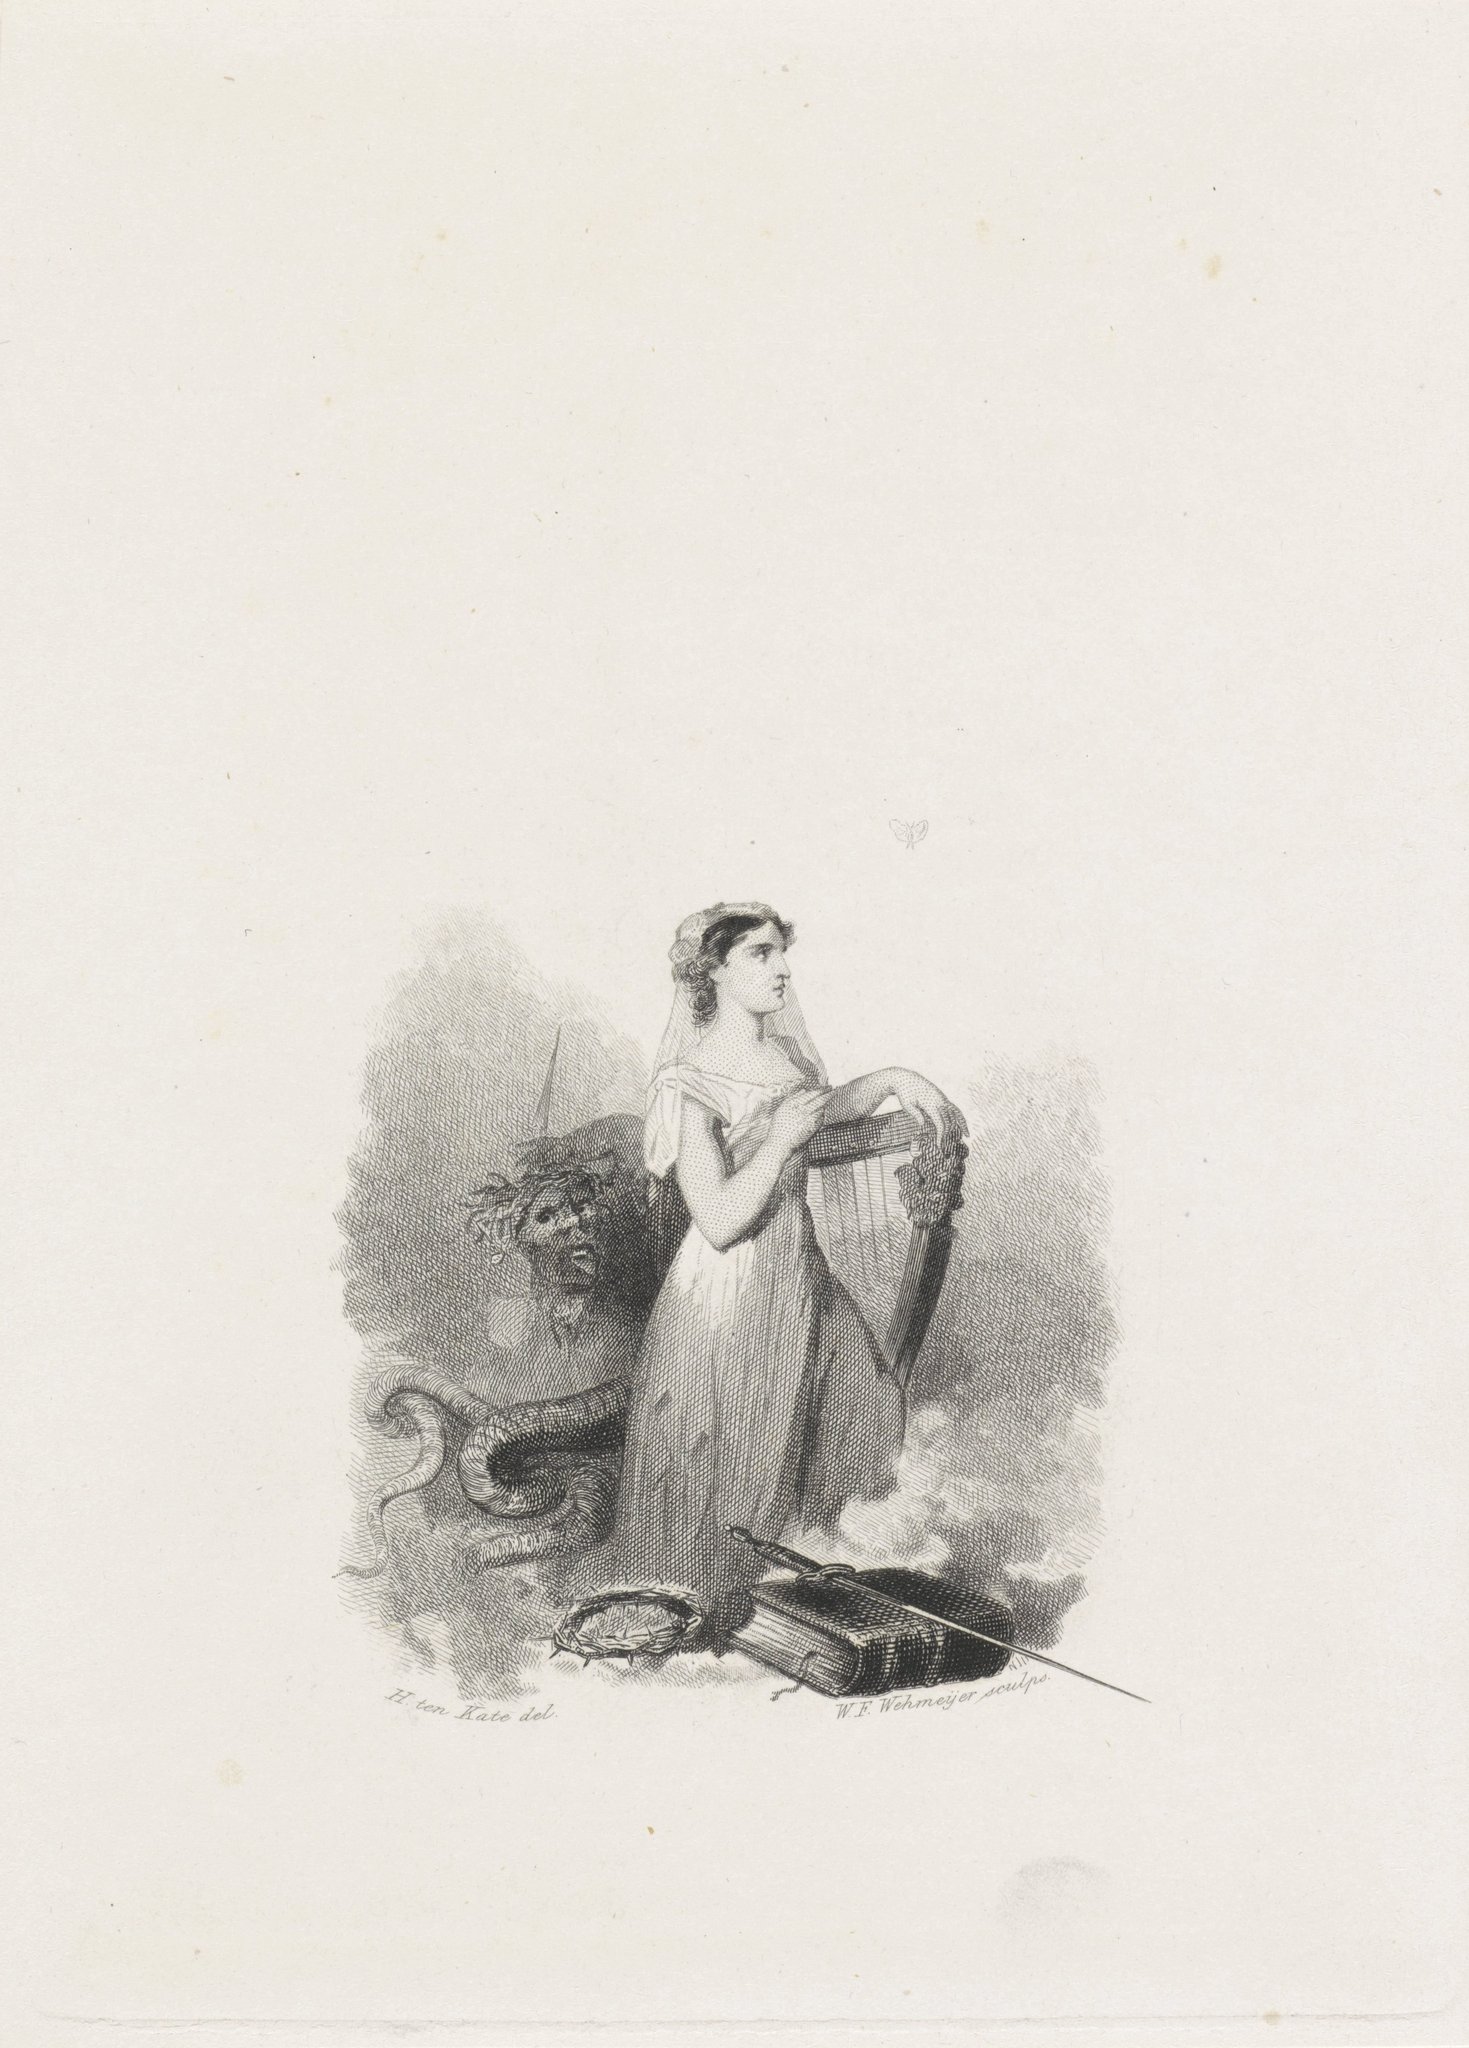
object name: print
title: Jonge vrouw met een harp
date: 1837-1854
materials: paper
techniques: engraving, etching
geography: amsterdam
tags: adolescent, young woman, maiden, snakes, hacking and thrusting weapons: sword, harp, book, crown of thorns ~ instruments of the passion, bride (in wedding-dress), insects: butterfly, mis-shapen animals; monsters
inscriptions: collector's mark: Lugt 2228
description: Een jonge vrouw in bruidskleding houdt een harp vast en kijkt naar een vlinder. Voor haar ligt een zwaard op een boek naast een doornenkroon. Achter haar zijn een slang en en monster weergegeven.